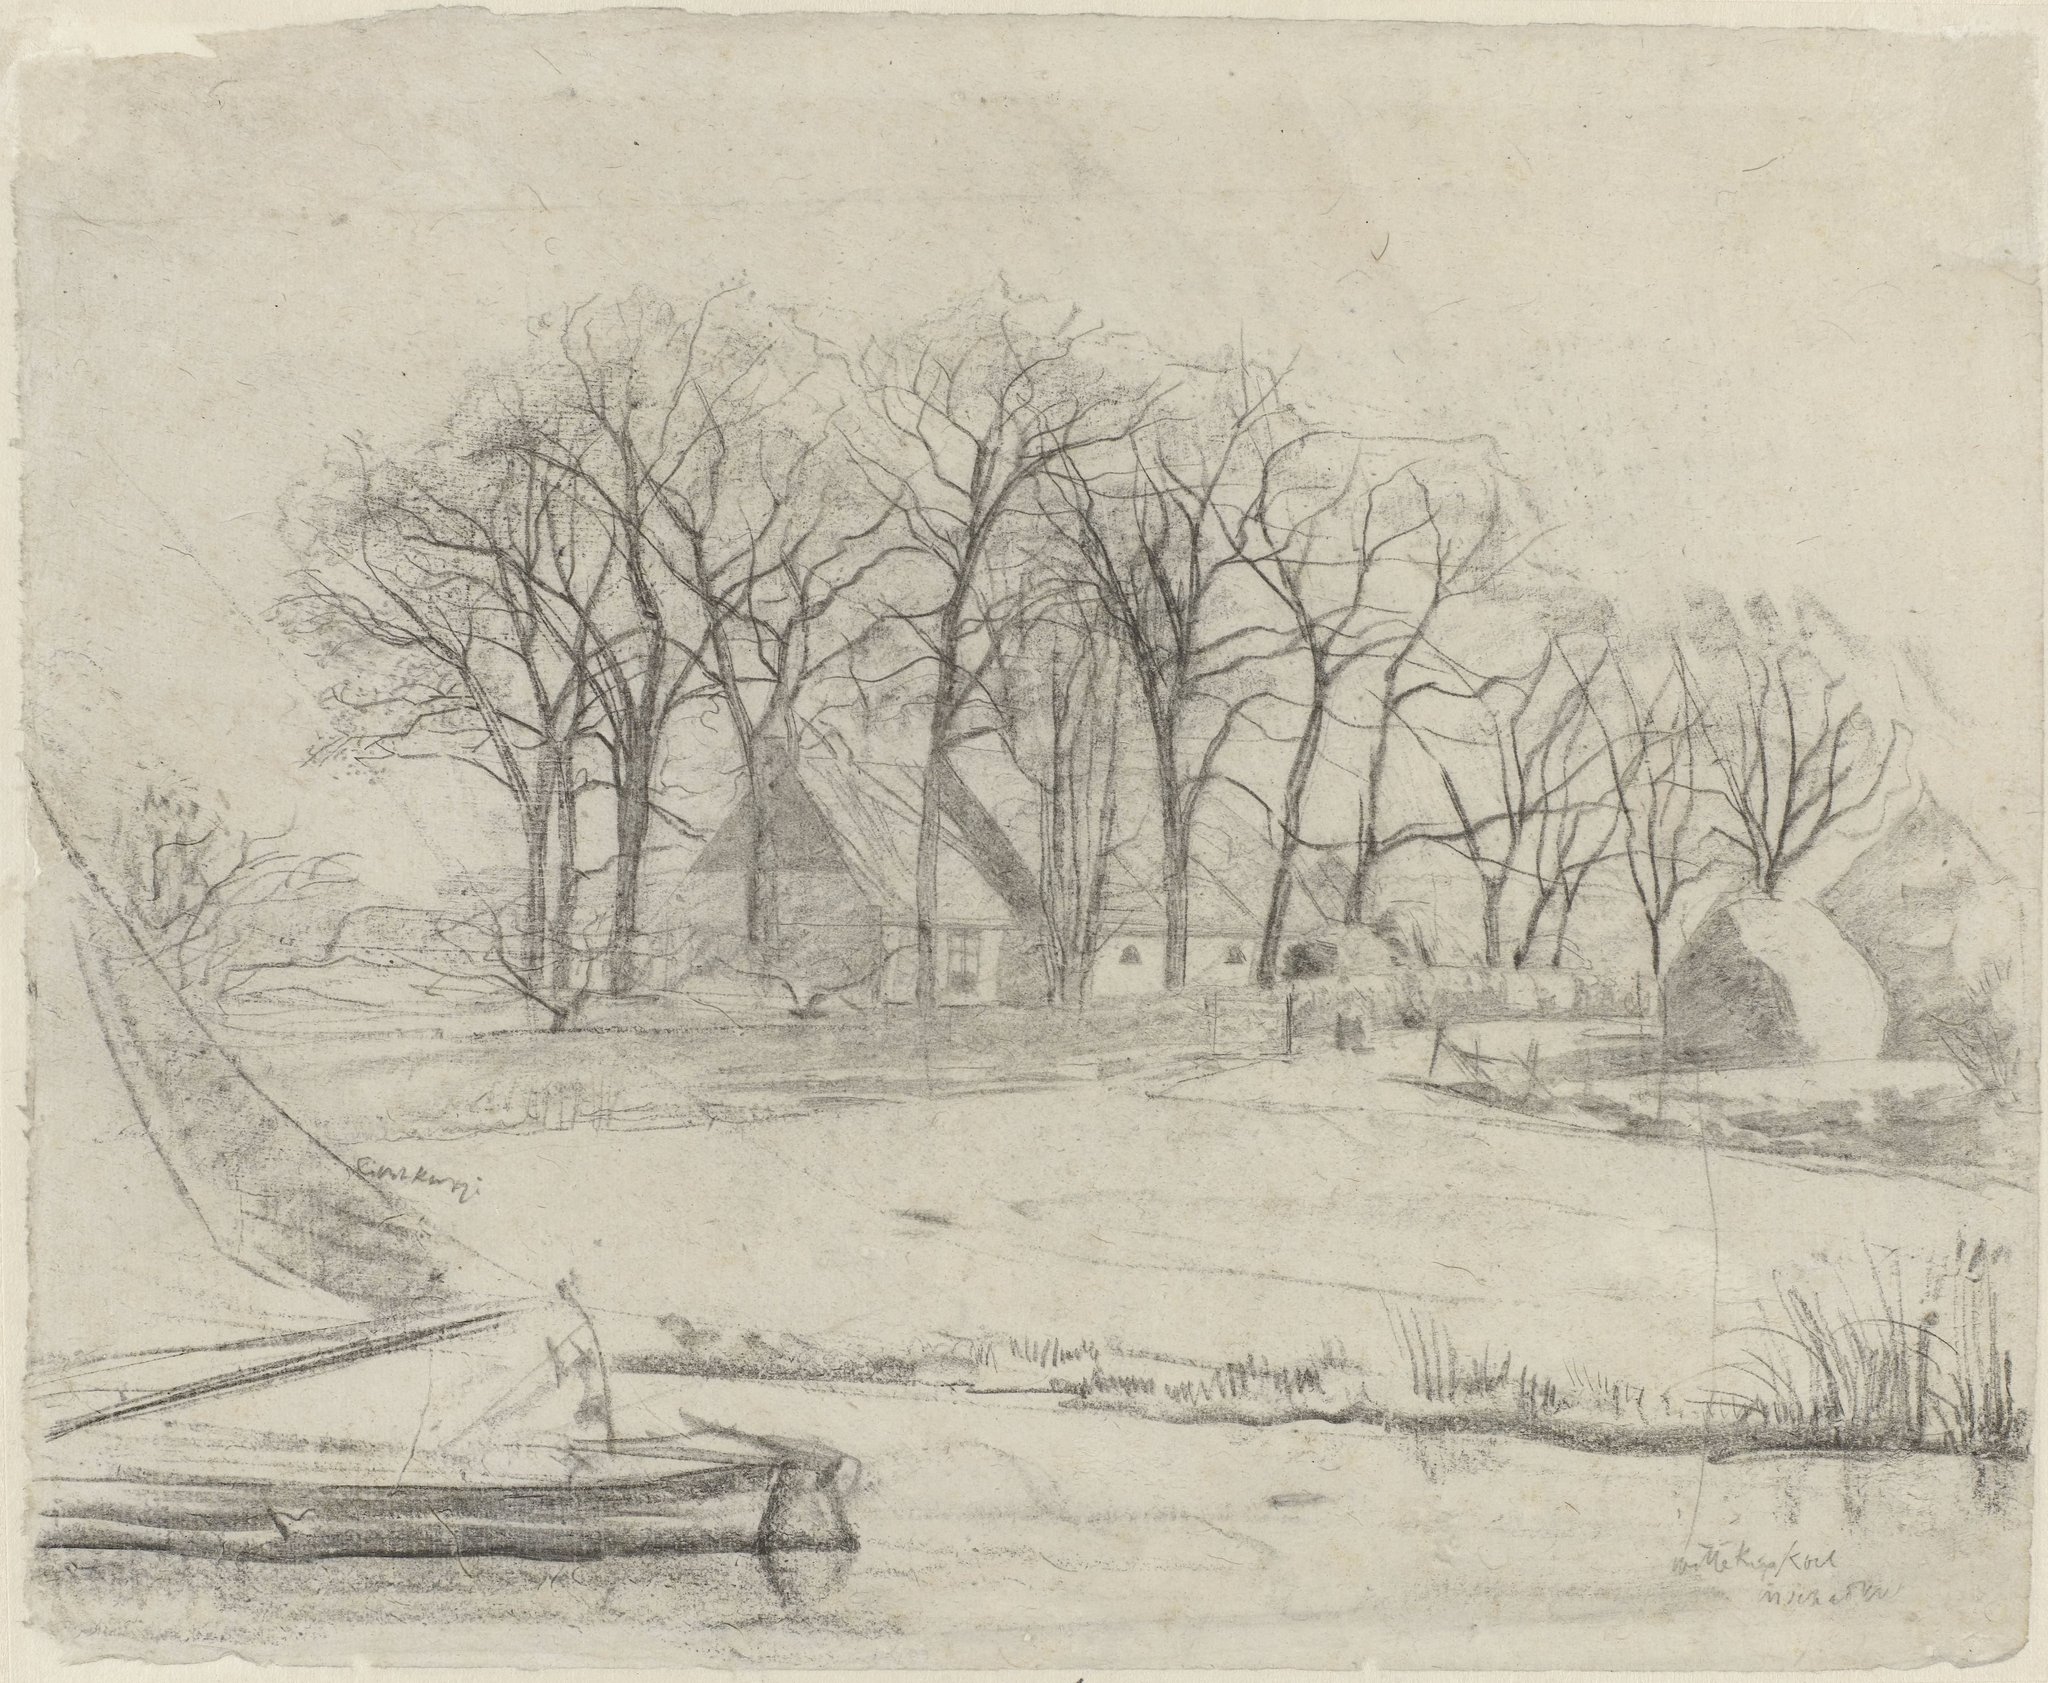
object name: drawing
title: Boerderij tussen bomen, bij een vaart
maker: gerrit willem dijsselhof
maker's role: designer, draughtsman, print maker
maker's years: 1866-1924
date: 1876-1924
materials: chalk, paper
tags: farm or solitary house in landscape